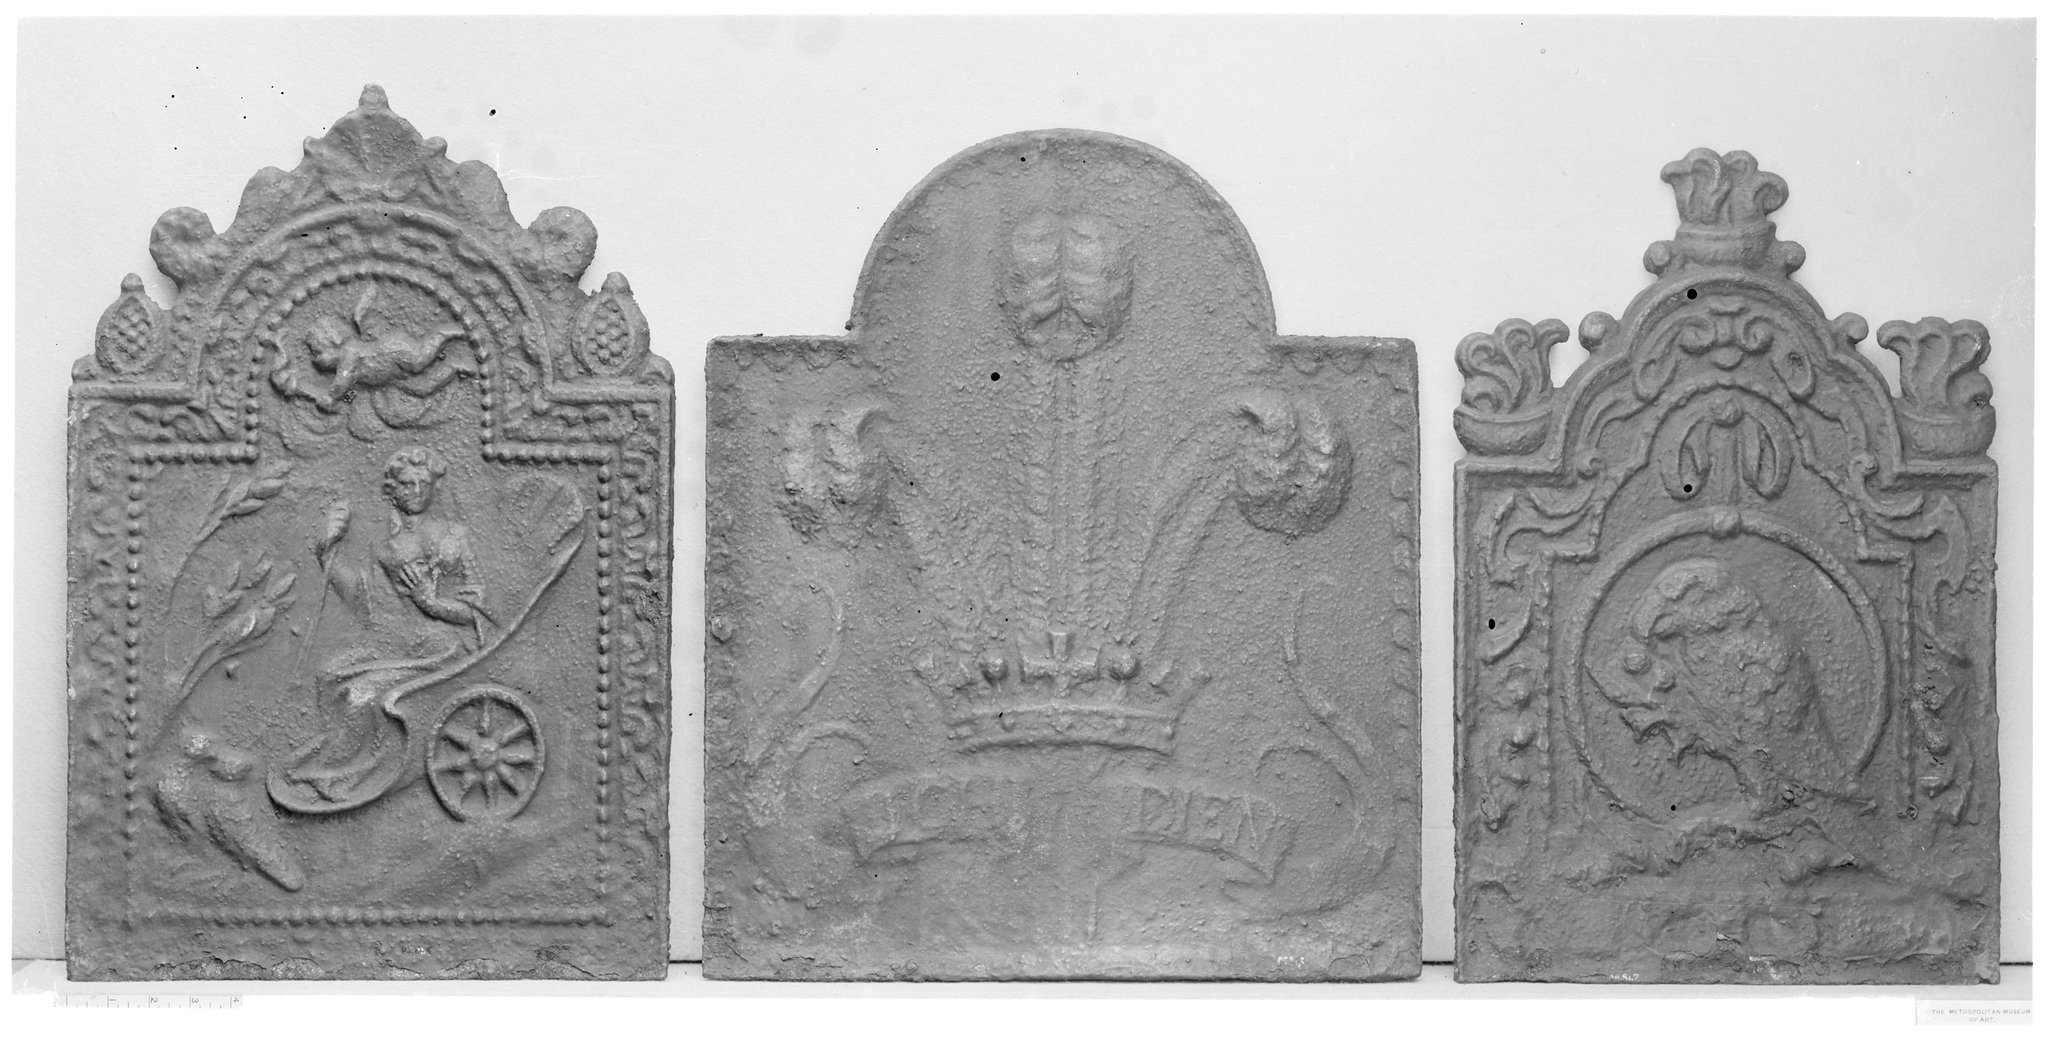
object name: fireback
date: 1701-1800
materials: iron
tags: birds